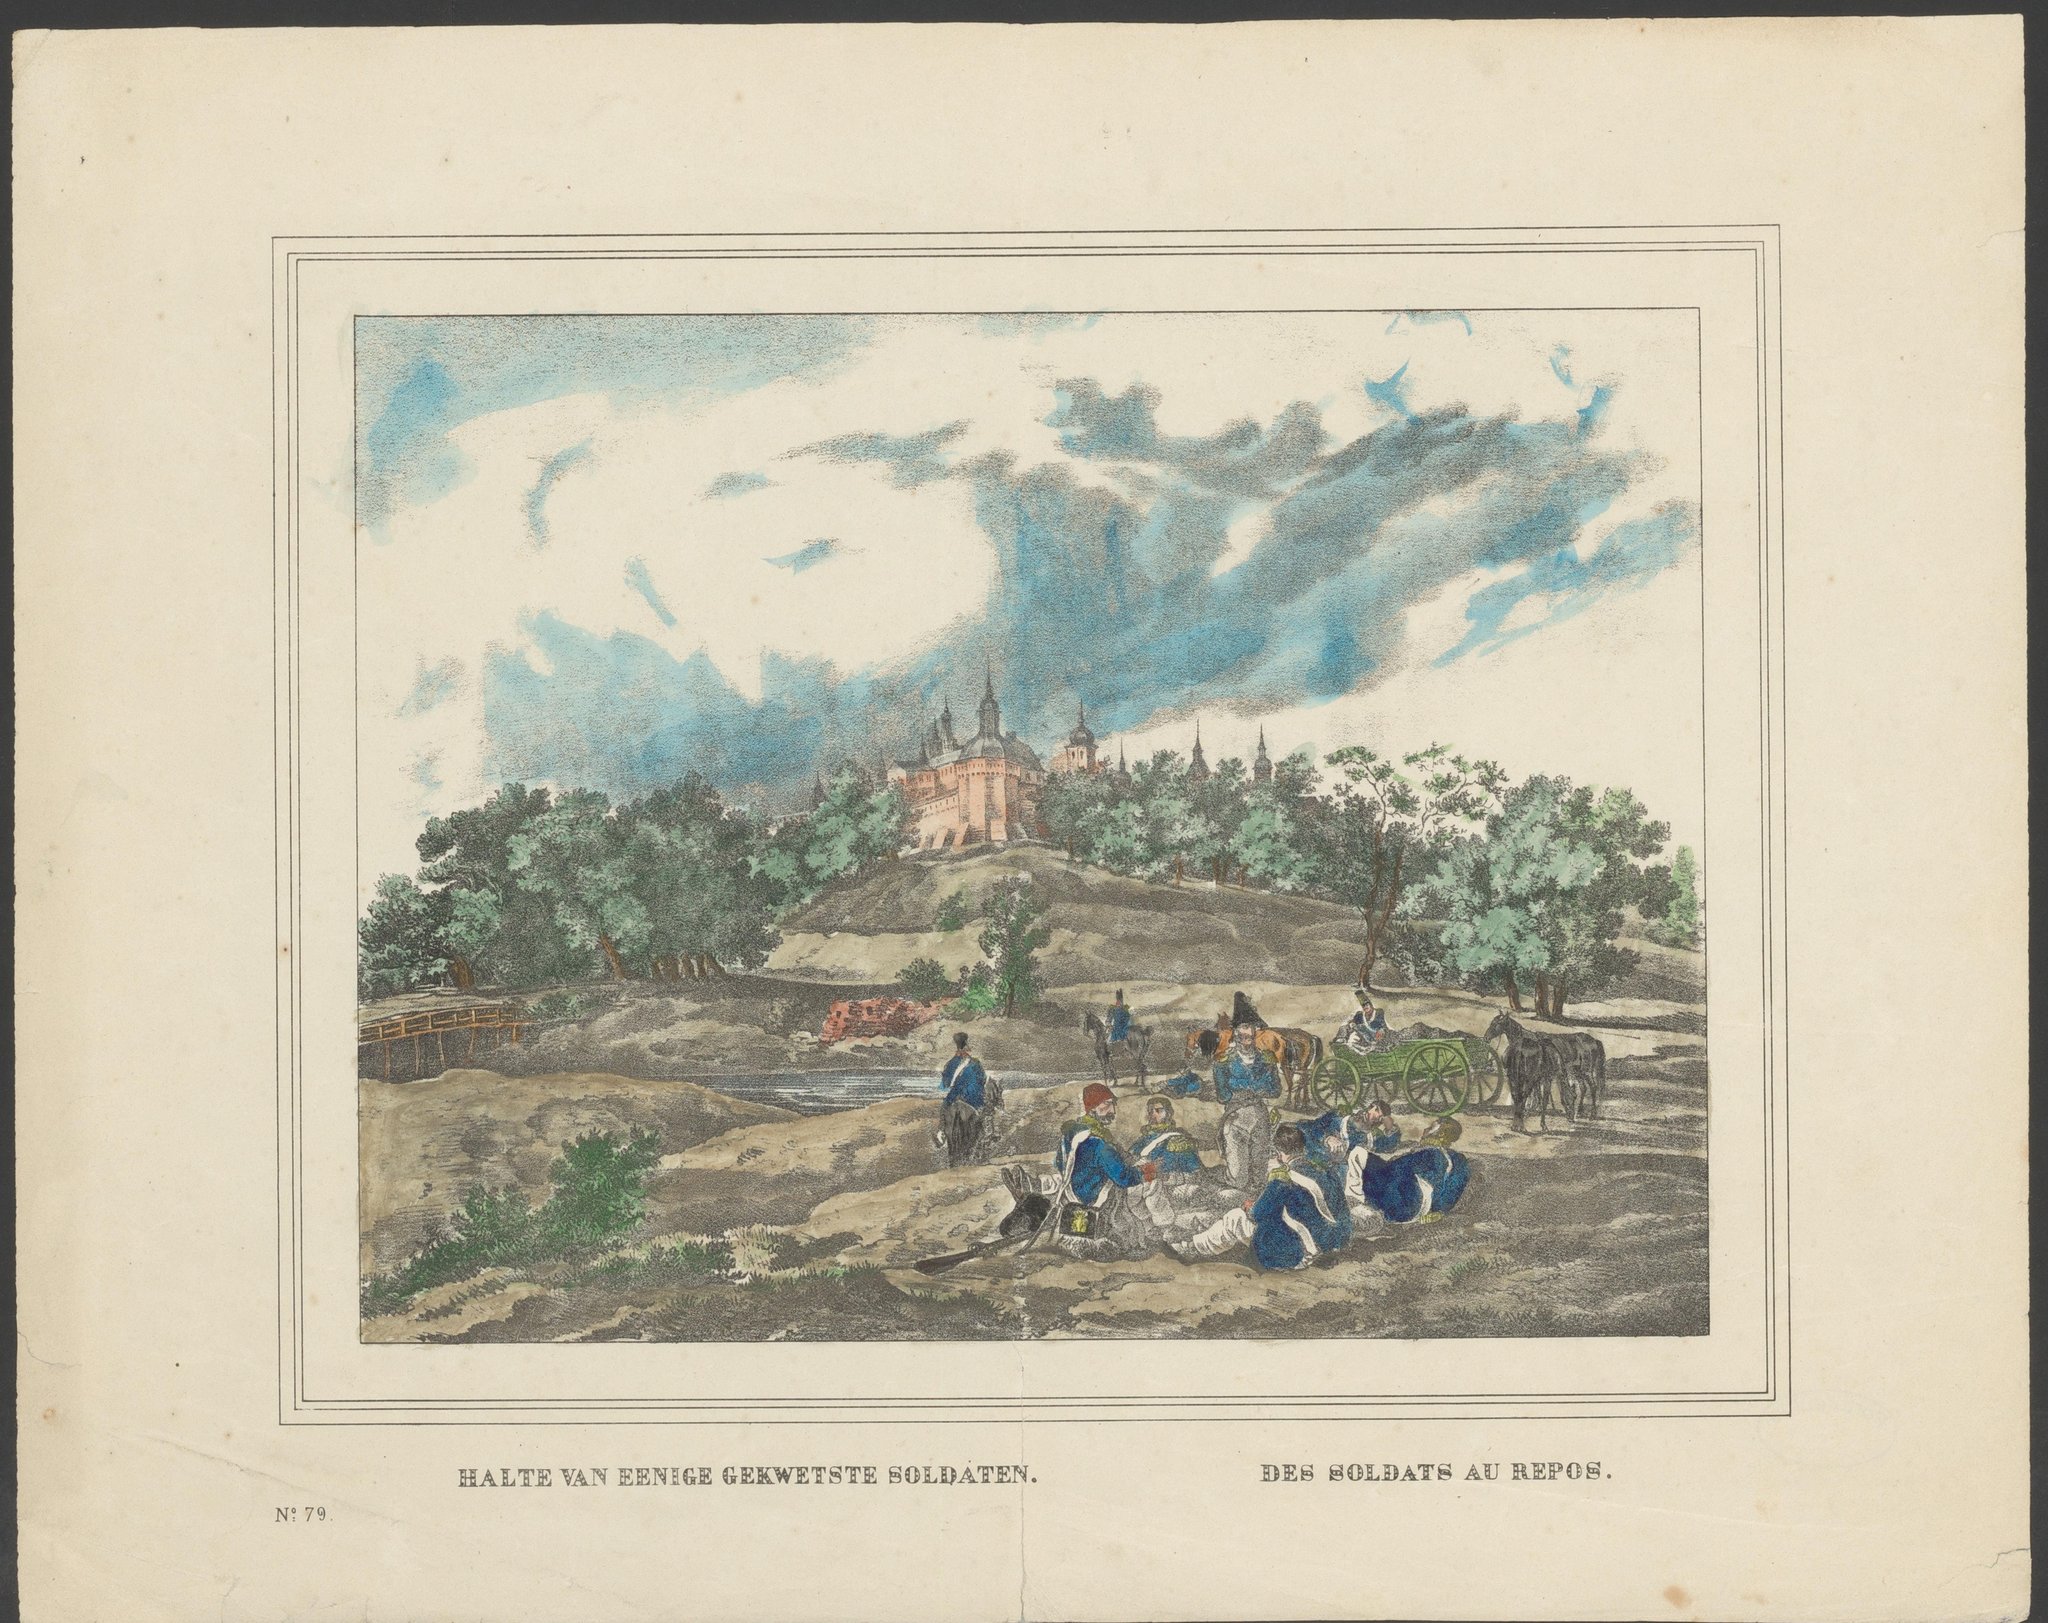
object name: print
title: Halte van eenige gekwetste soldaten / Des soldats au repos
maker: Anonymous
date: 1800-1899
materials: paper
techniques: hand coloring, lithograph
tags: the company, the unit, the troop ~ military service, the soldier; the soldier's life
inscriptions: collector's mark: Lugt 1641, stamp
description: Linksonder genummerd: No. 79. Onderwerpsrubrieken binnen de Atlas Zeden en Gewoonten: Zeden en Gewoonten in Engeren Zin, Des menschen beging, midden en einde, Kinderleven – Kinderspel en Kinderprenten.